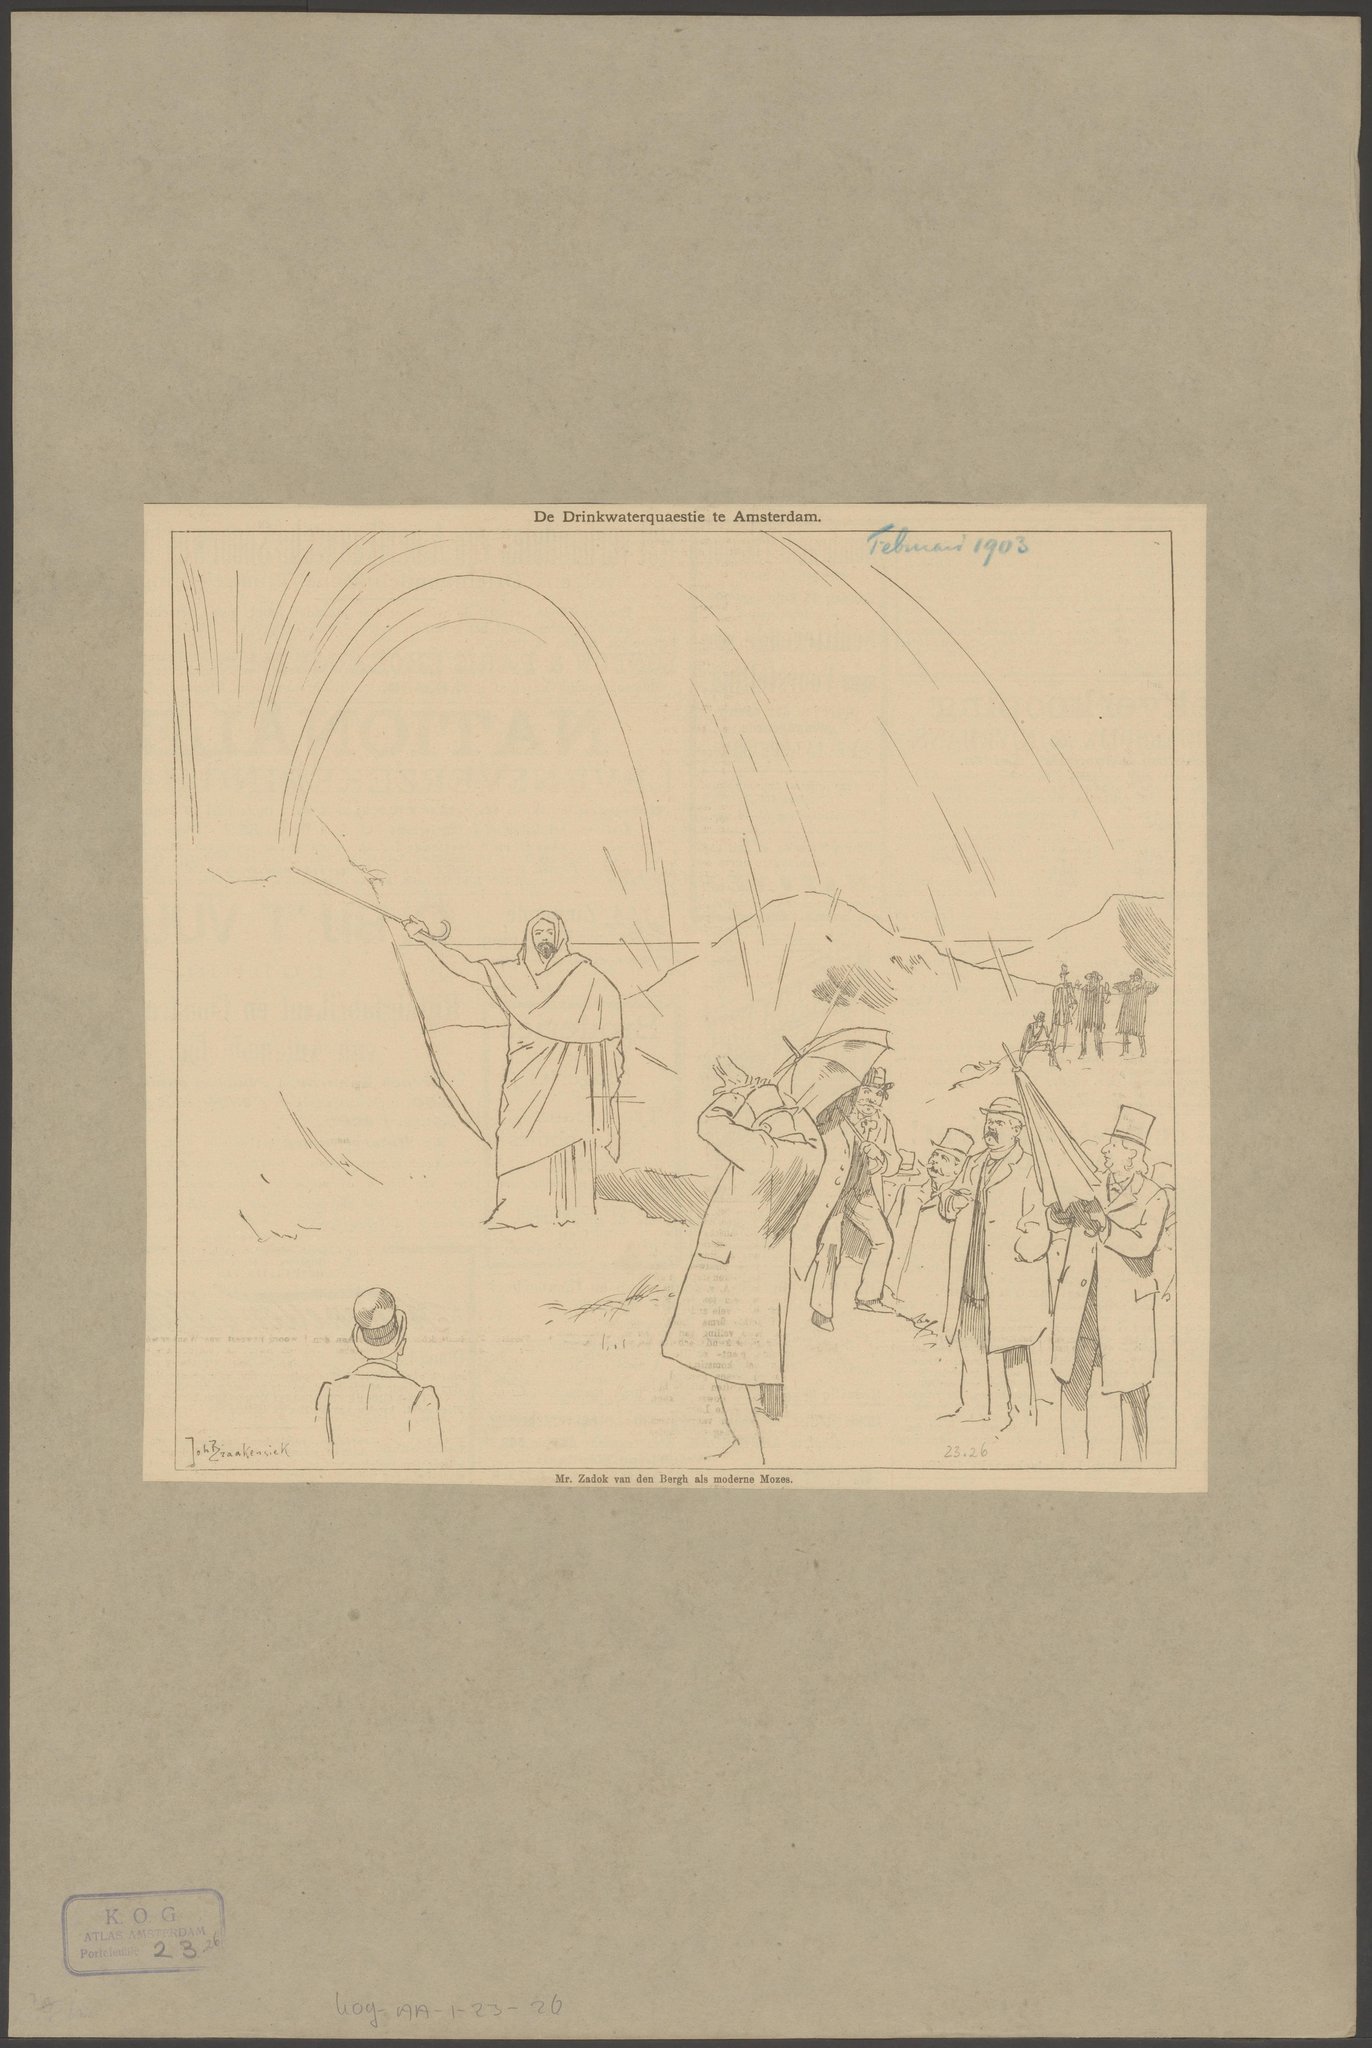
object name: photomechanical print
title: De Drinkwaterquaestie te Amsterdam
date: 1903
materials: paper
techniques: letterpress printing, line block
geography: amsterdam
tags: water-supply (~ public services), passage through the red sea, political caricatures and satires, amsterdam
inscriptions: collector's mark: Lugt 1641b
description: Prent uit: De Amsterdammer 27 (1903), nr. 1338, 15 februari 1903, p. 11.